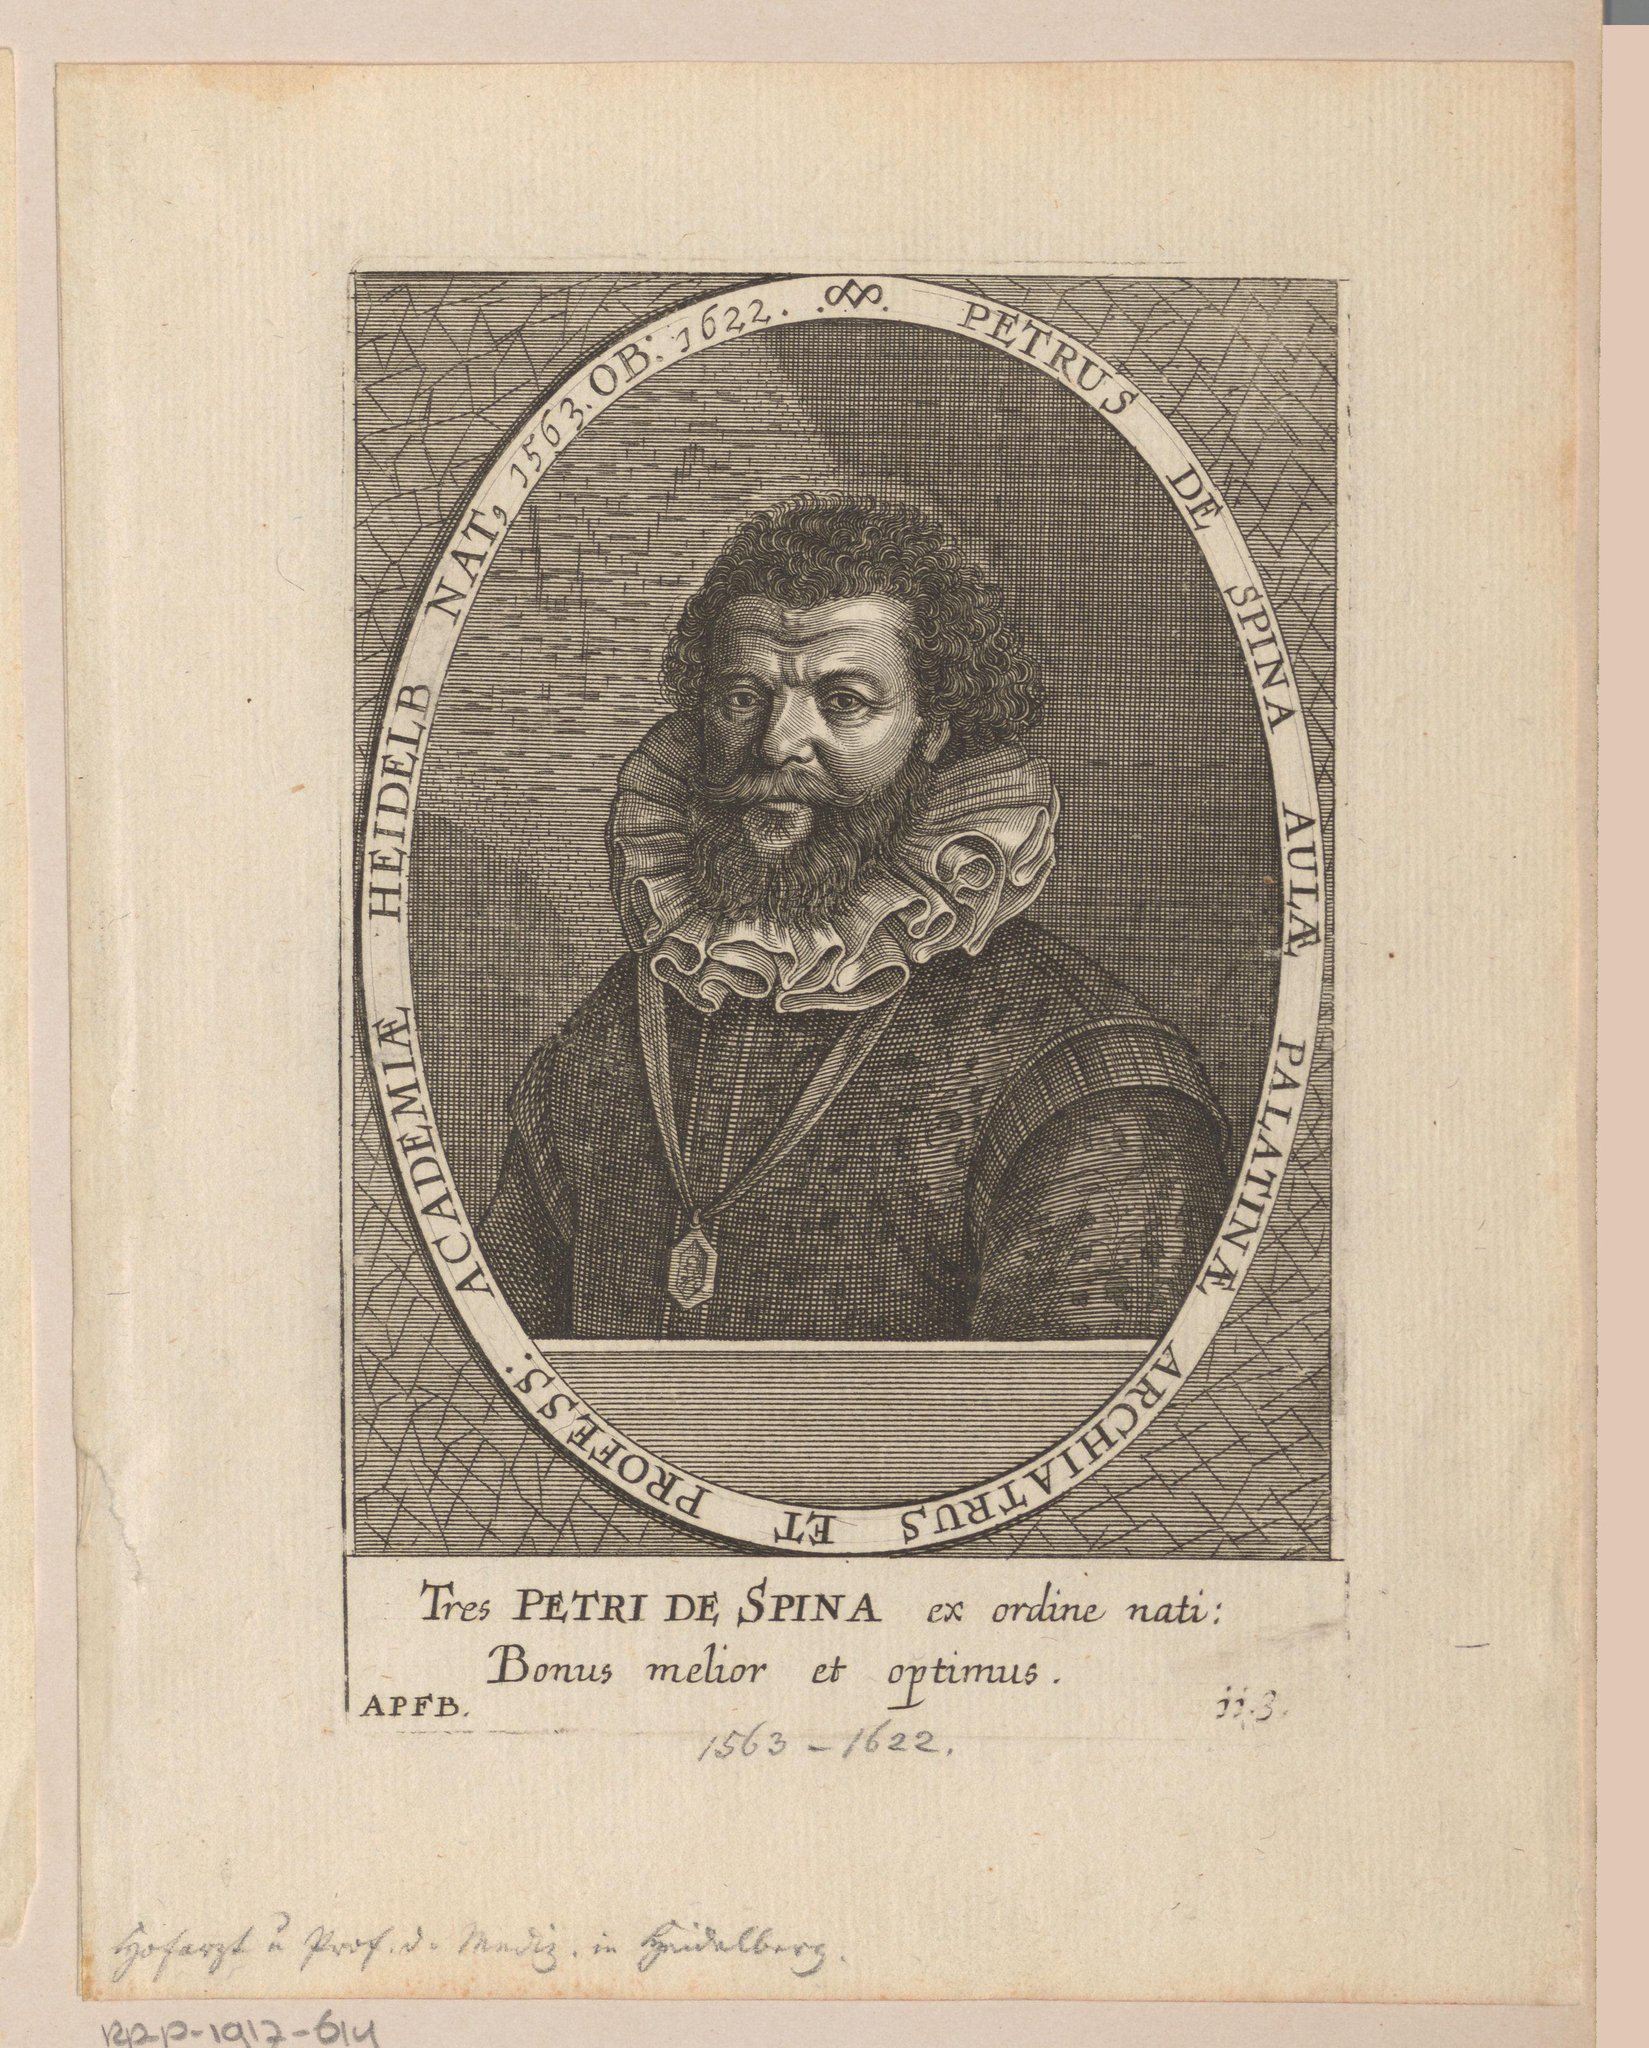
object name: print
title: Portret van Peter Spina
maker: Anonymous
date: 1650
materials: paper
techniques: engraving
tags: historical persons, physician, doctor (+ portrait of scholar, scientist)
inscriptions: collector's mark: Lugt 2228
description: Eerdere staat van de prent gebruikt in: Boissard, Jean Jacques. Bibliotheca chalcographica. Frankfurt am Main: Johannes Ammon, 1650. Ook gebruikt in de editie uit 1669.